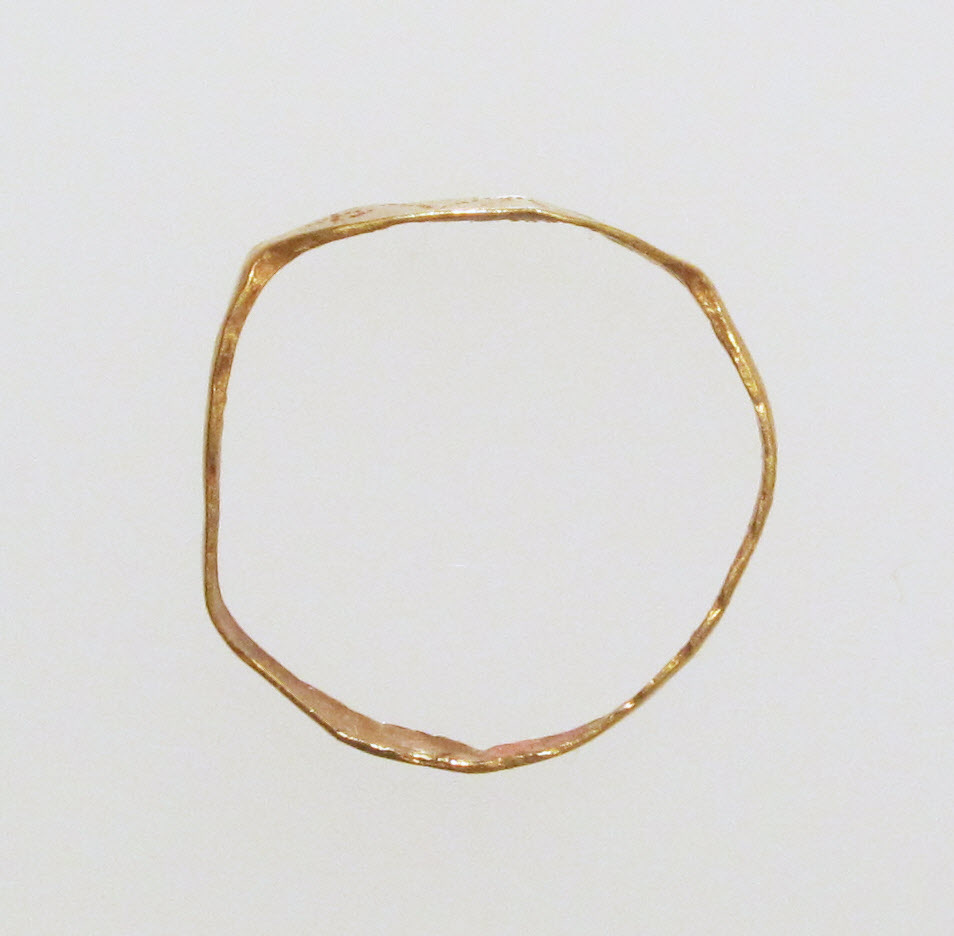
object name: ring, motto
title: Gold ring with inscription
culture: roman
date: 100 BCE-300 CE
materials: gold